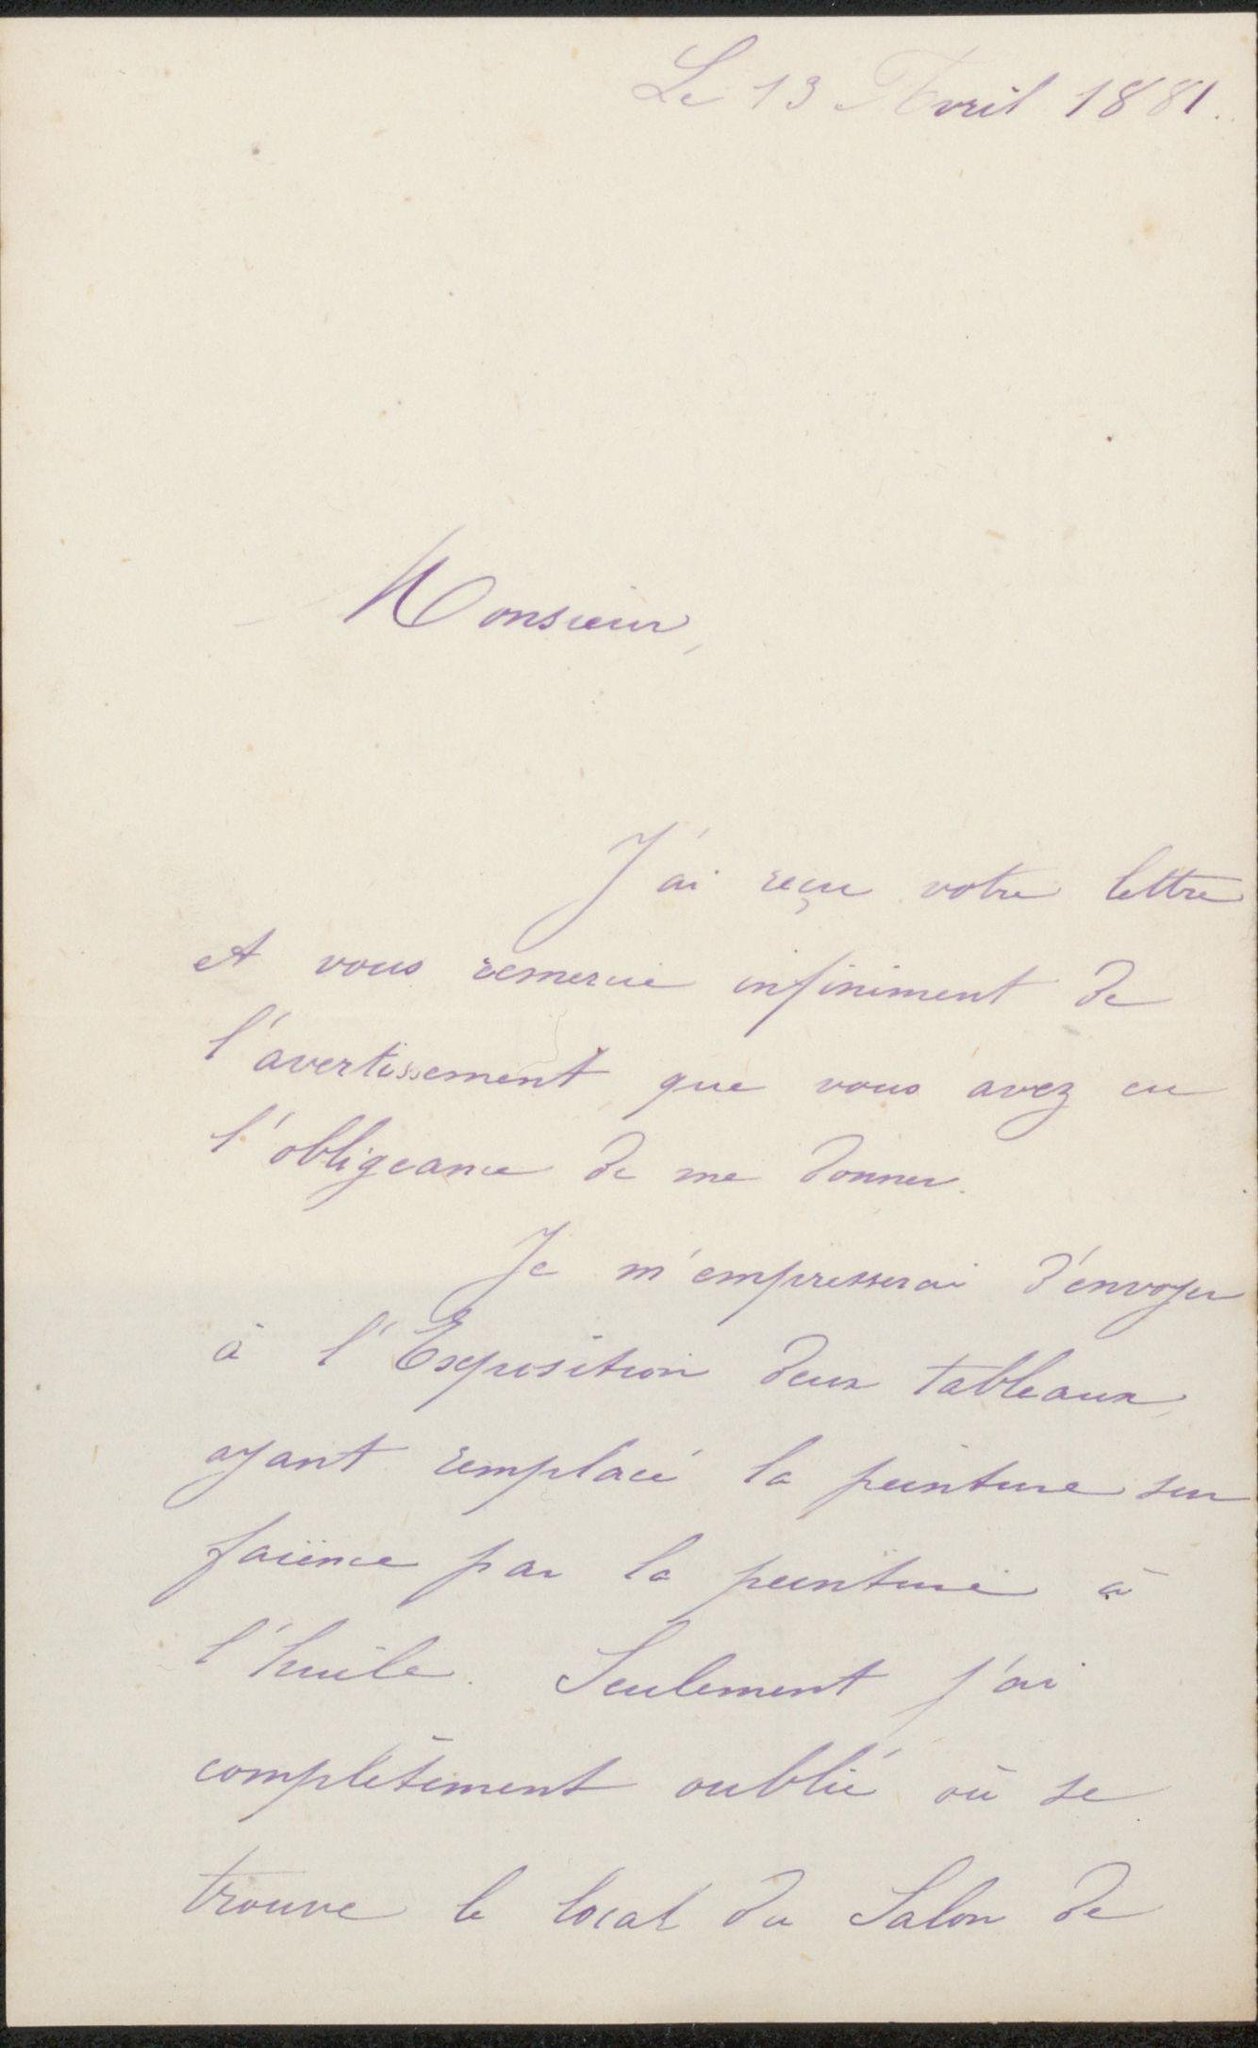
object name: letter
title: Brief aan Philip Zilcken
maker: georgette meunier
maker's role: painter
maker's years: 1859-1951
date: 1881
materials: ink, paper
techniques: pen, writing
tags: the hague, draughtsman, philip zilcken, applied arts, arts and crafts; industrial design, painting (including book-illumination, miniature-painting), exhibition ~ art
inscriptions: watermark, collector's mark: ‘RPK’